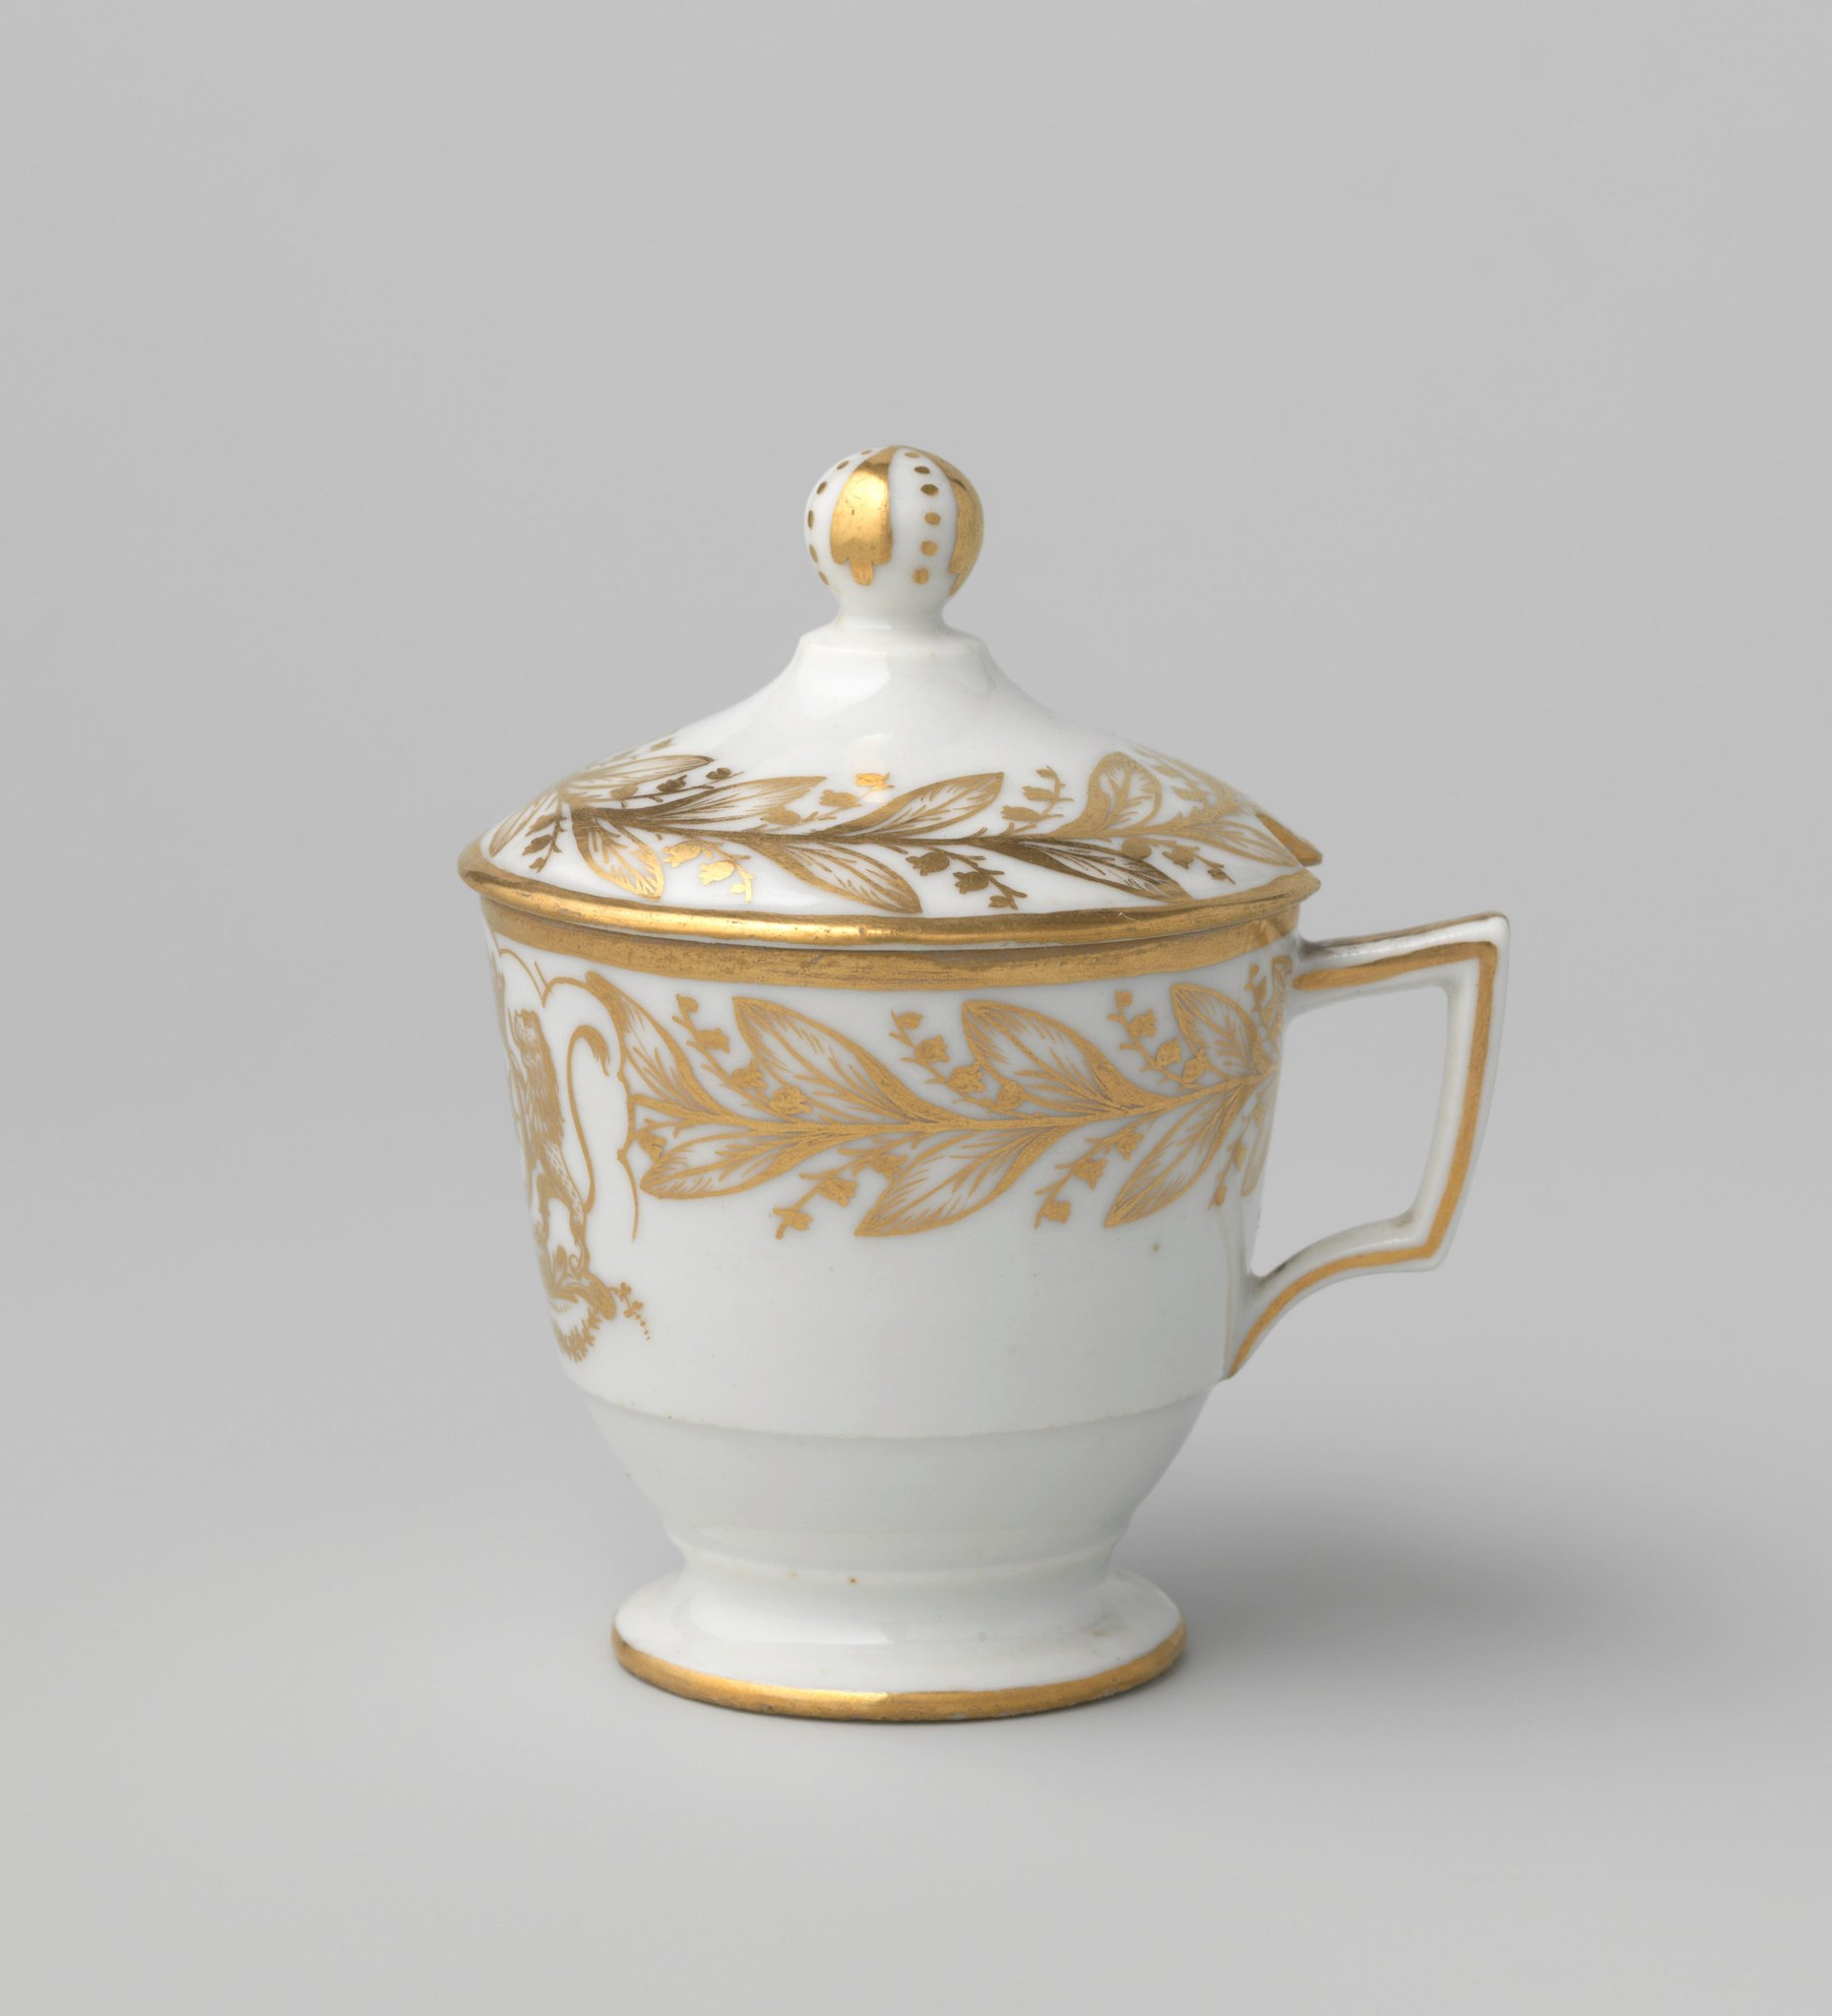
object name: lid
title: Cover of a mustard pot with the coat of arms of Hendrik Peter Godfried Quack and Isabella Gertraud von Carnap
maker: Anonymous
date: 1790-1800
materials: glaze, gold, paint, porcelain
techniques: firing, forming, gilding, turning, vitrification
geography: netherlands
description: Deksel van een mosterpot van porselein, beschilderd op het glazuur met goud. Versierd met een bloemrank en ronde dekselknop. In de rand van de deksel zit een uitsparing voor een lepel.